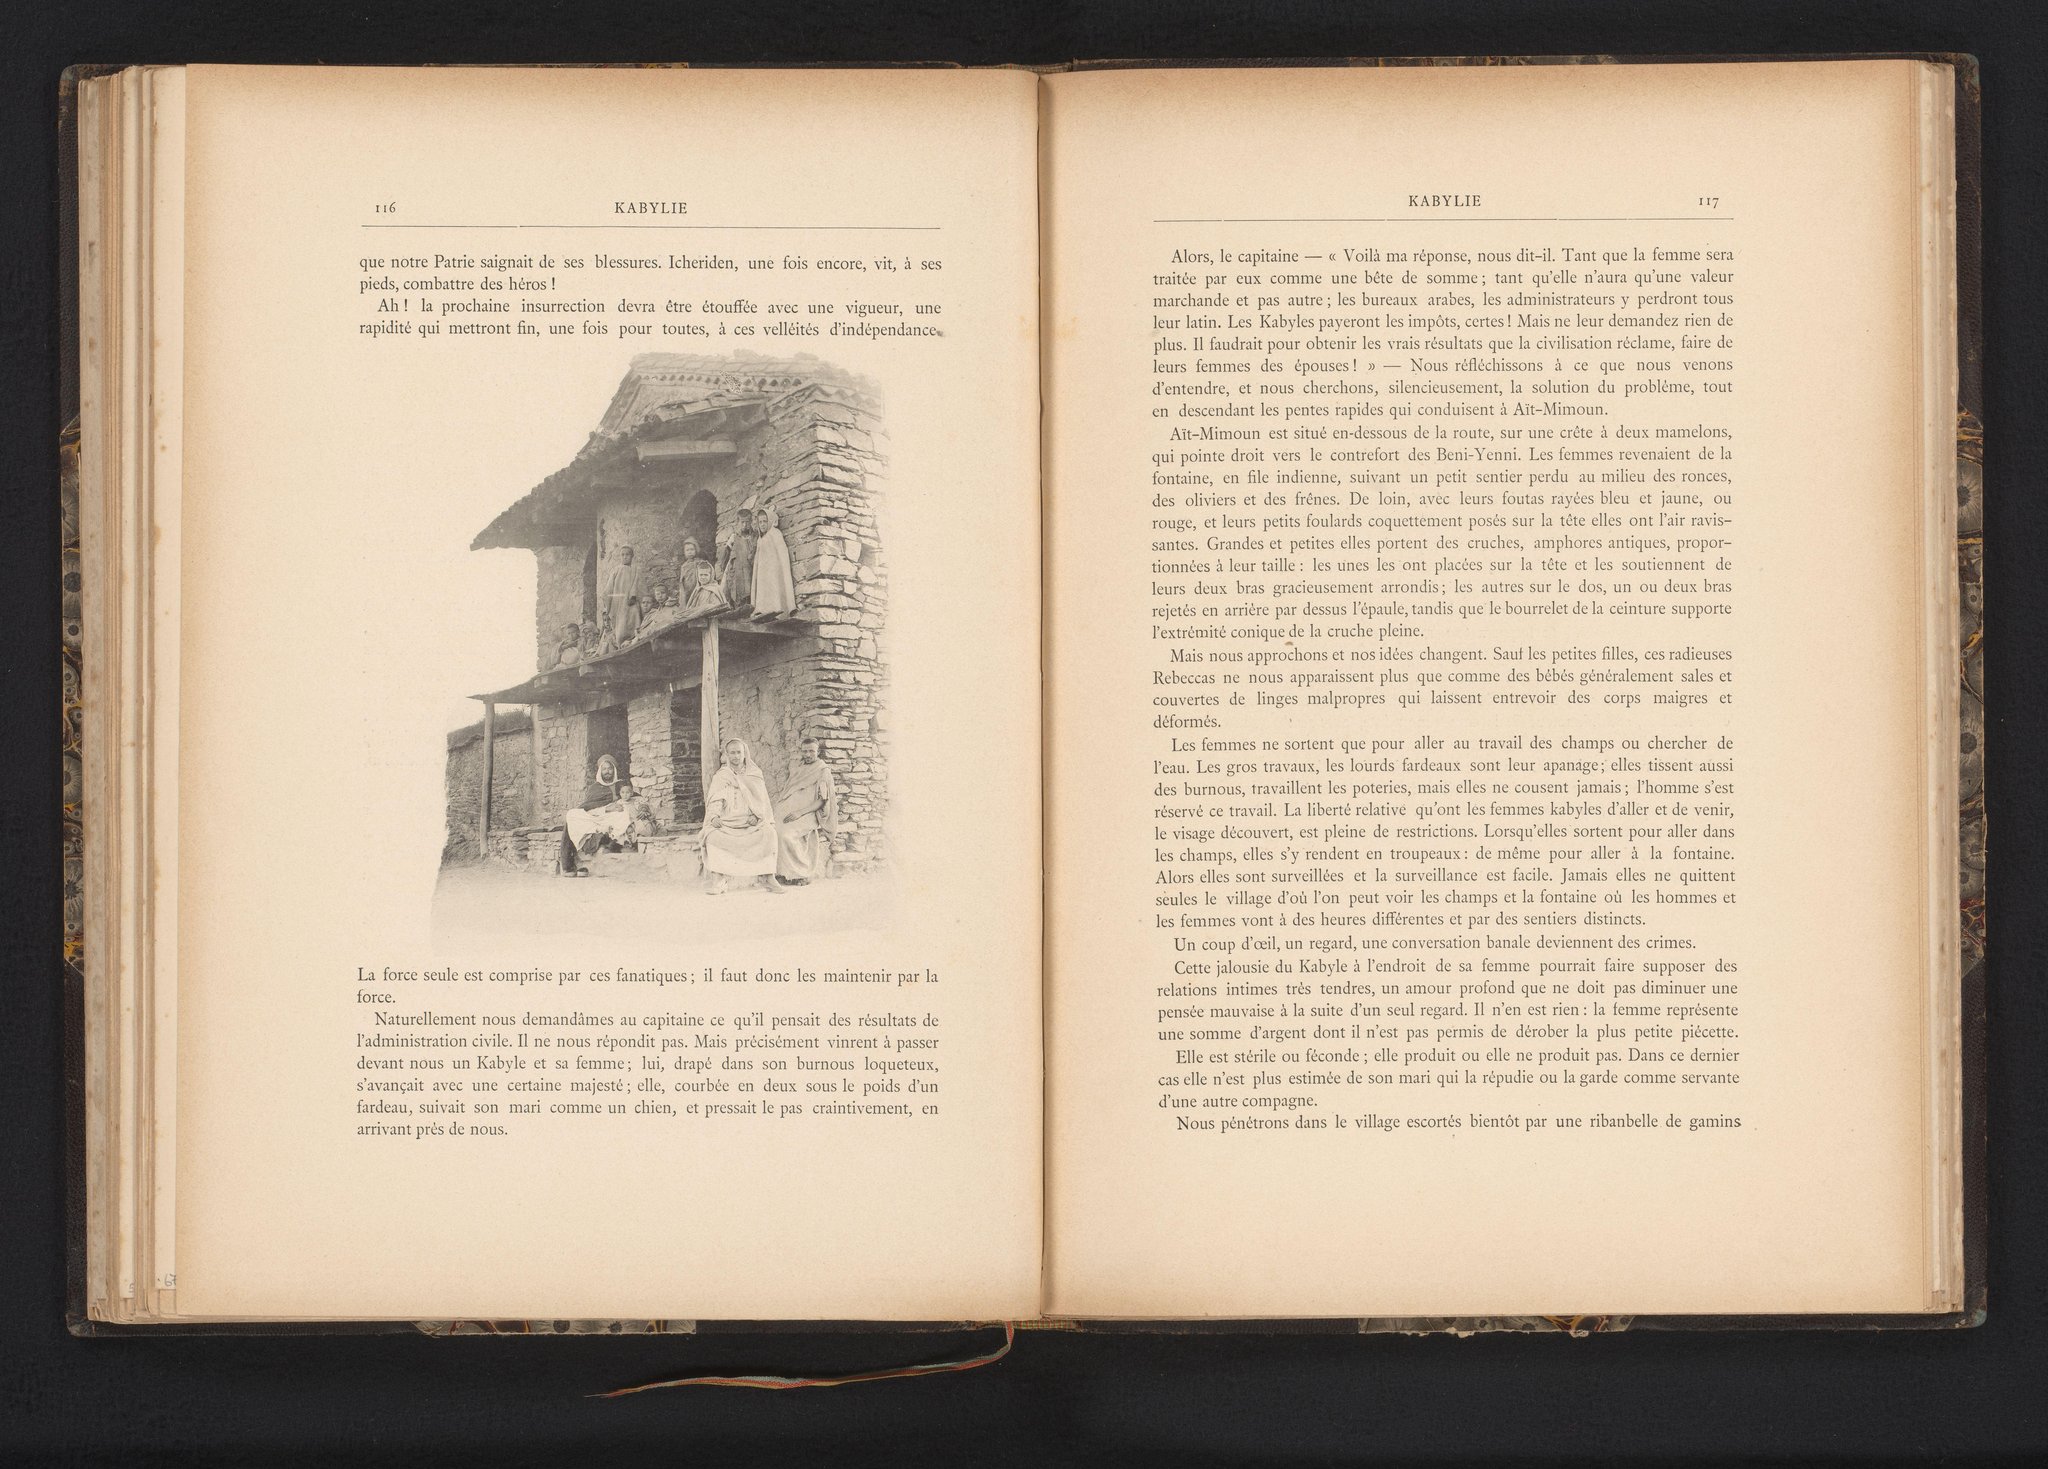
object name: page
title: Groep mannen en jongens voor een huis in Kabylië, Algerije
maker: jules gervais-courtellemont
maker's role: fotograaf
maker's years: 1863-1931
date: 1888-1893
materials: paper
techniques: photograph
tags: boy (child between toddler and youth), adult man, civic architecture; edifices; dwellings